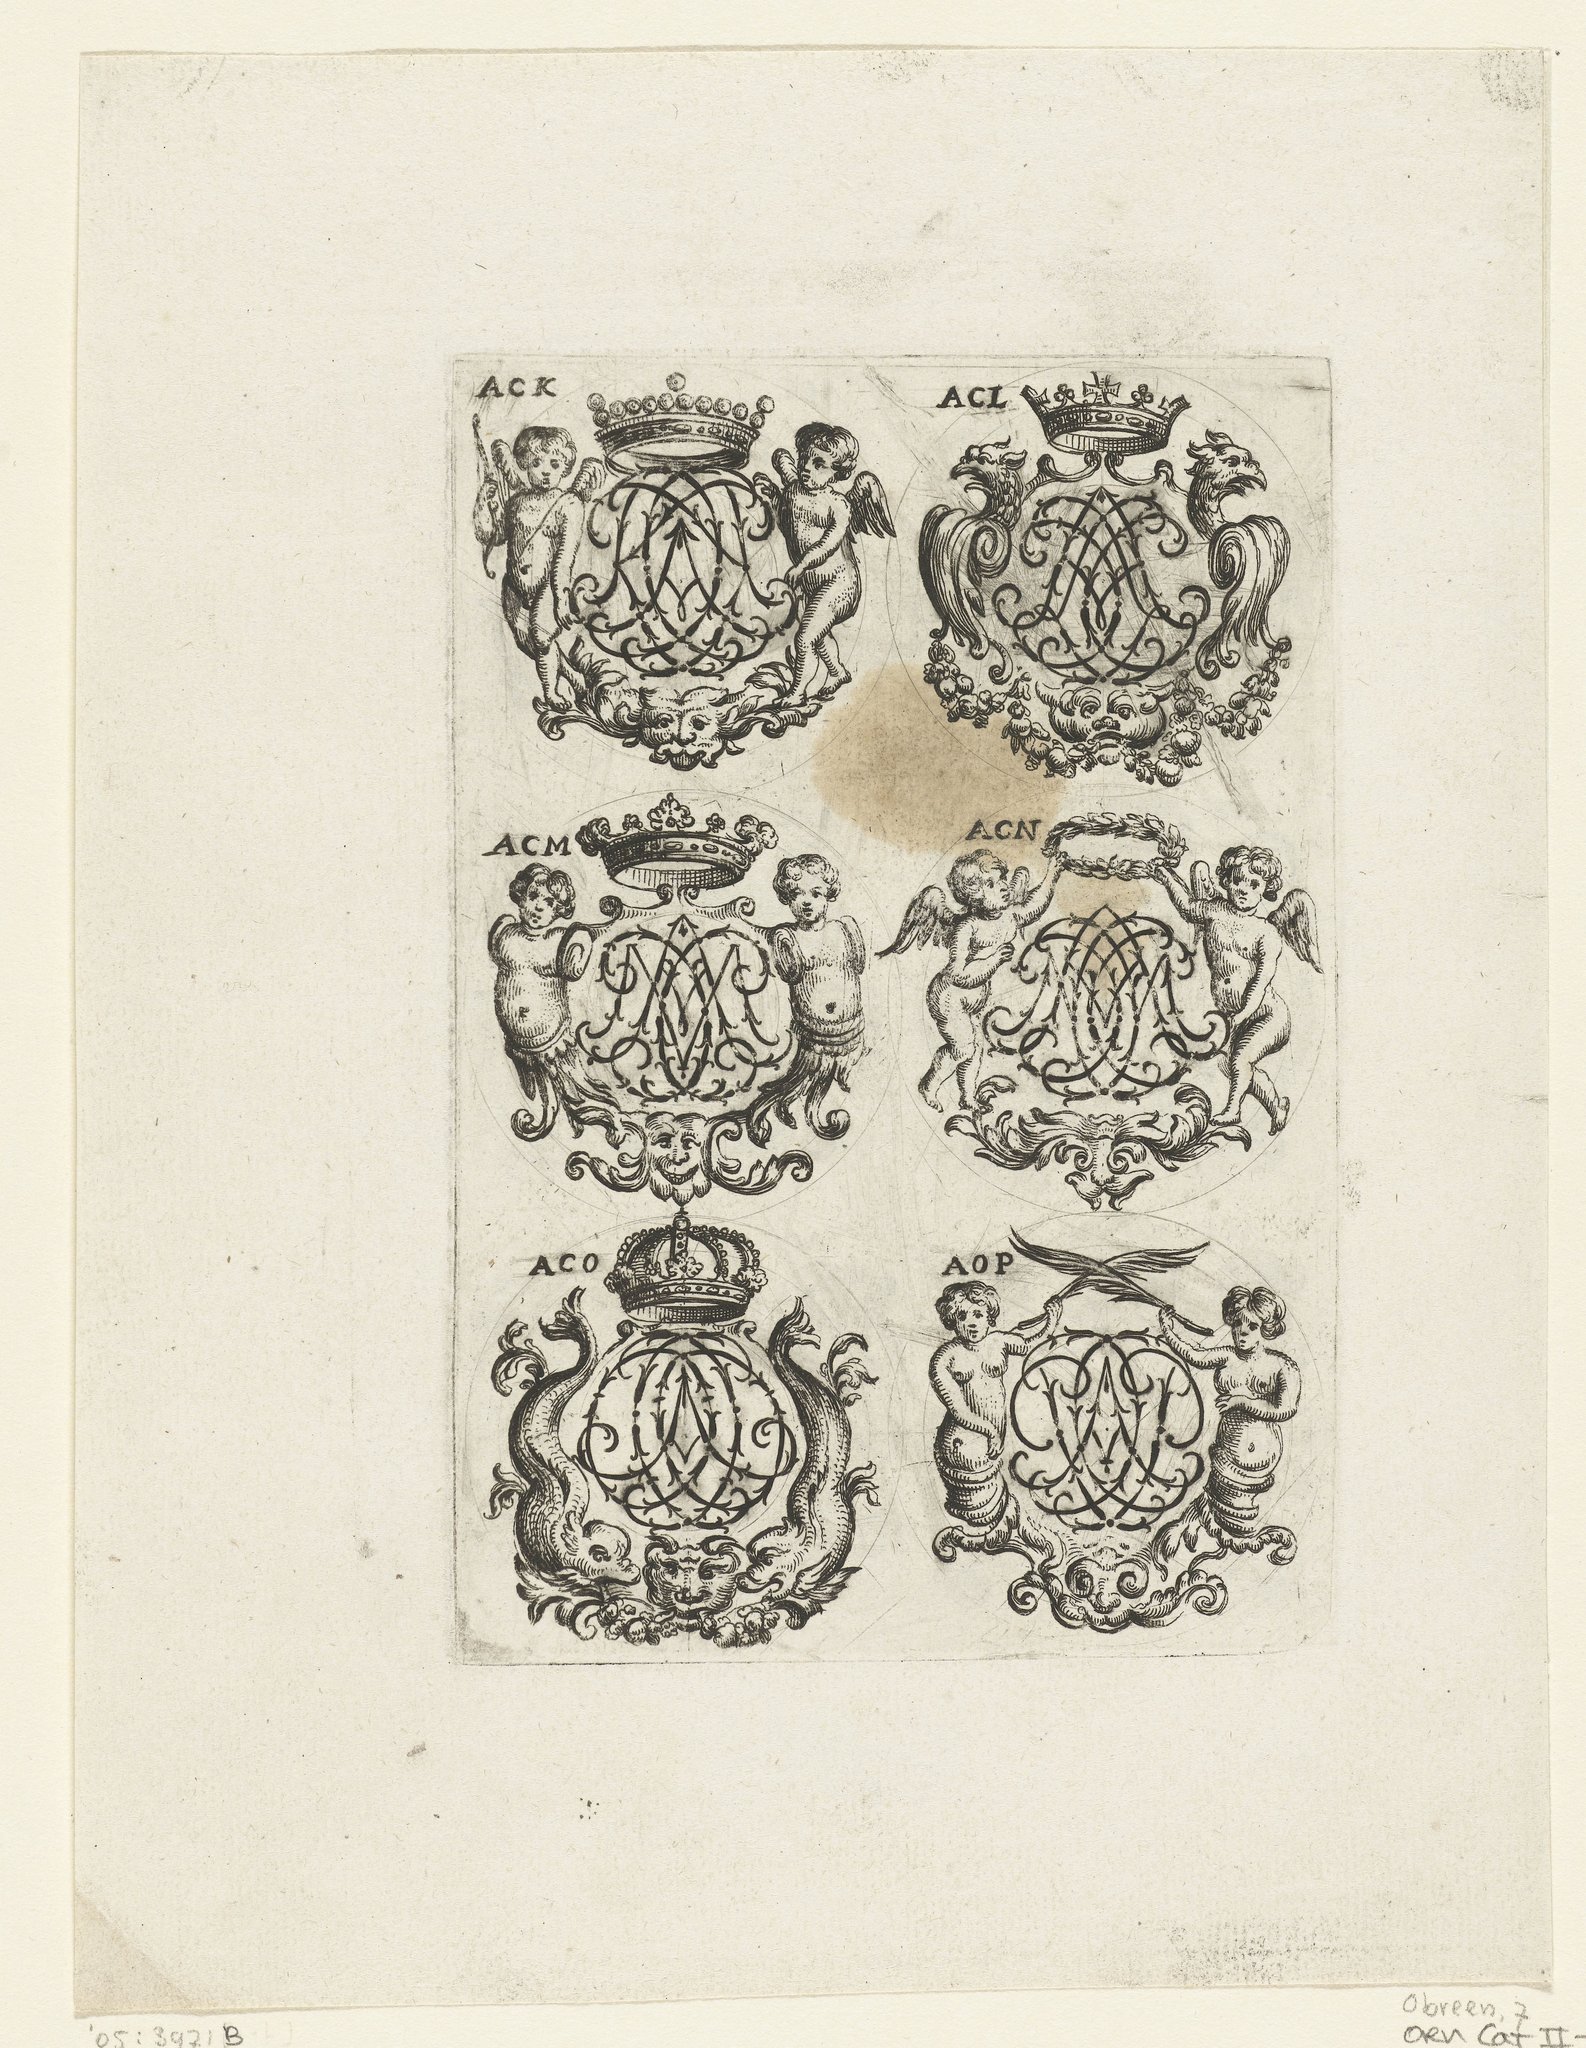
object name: ornament print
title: Livre nouveau et utile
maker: daniel de lafeuille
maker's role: print maker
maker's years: 1640-1709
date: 1690-1691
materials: paper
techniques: engraving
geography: amsterdam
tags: letters, alphabet, script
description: Uit serie van 29 deels genummerde bladen met cijfermonogrammen.